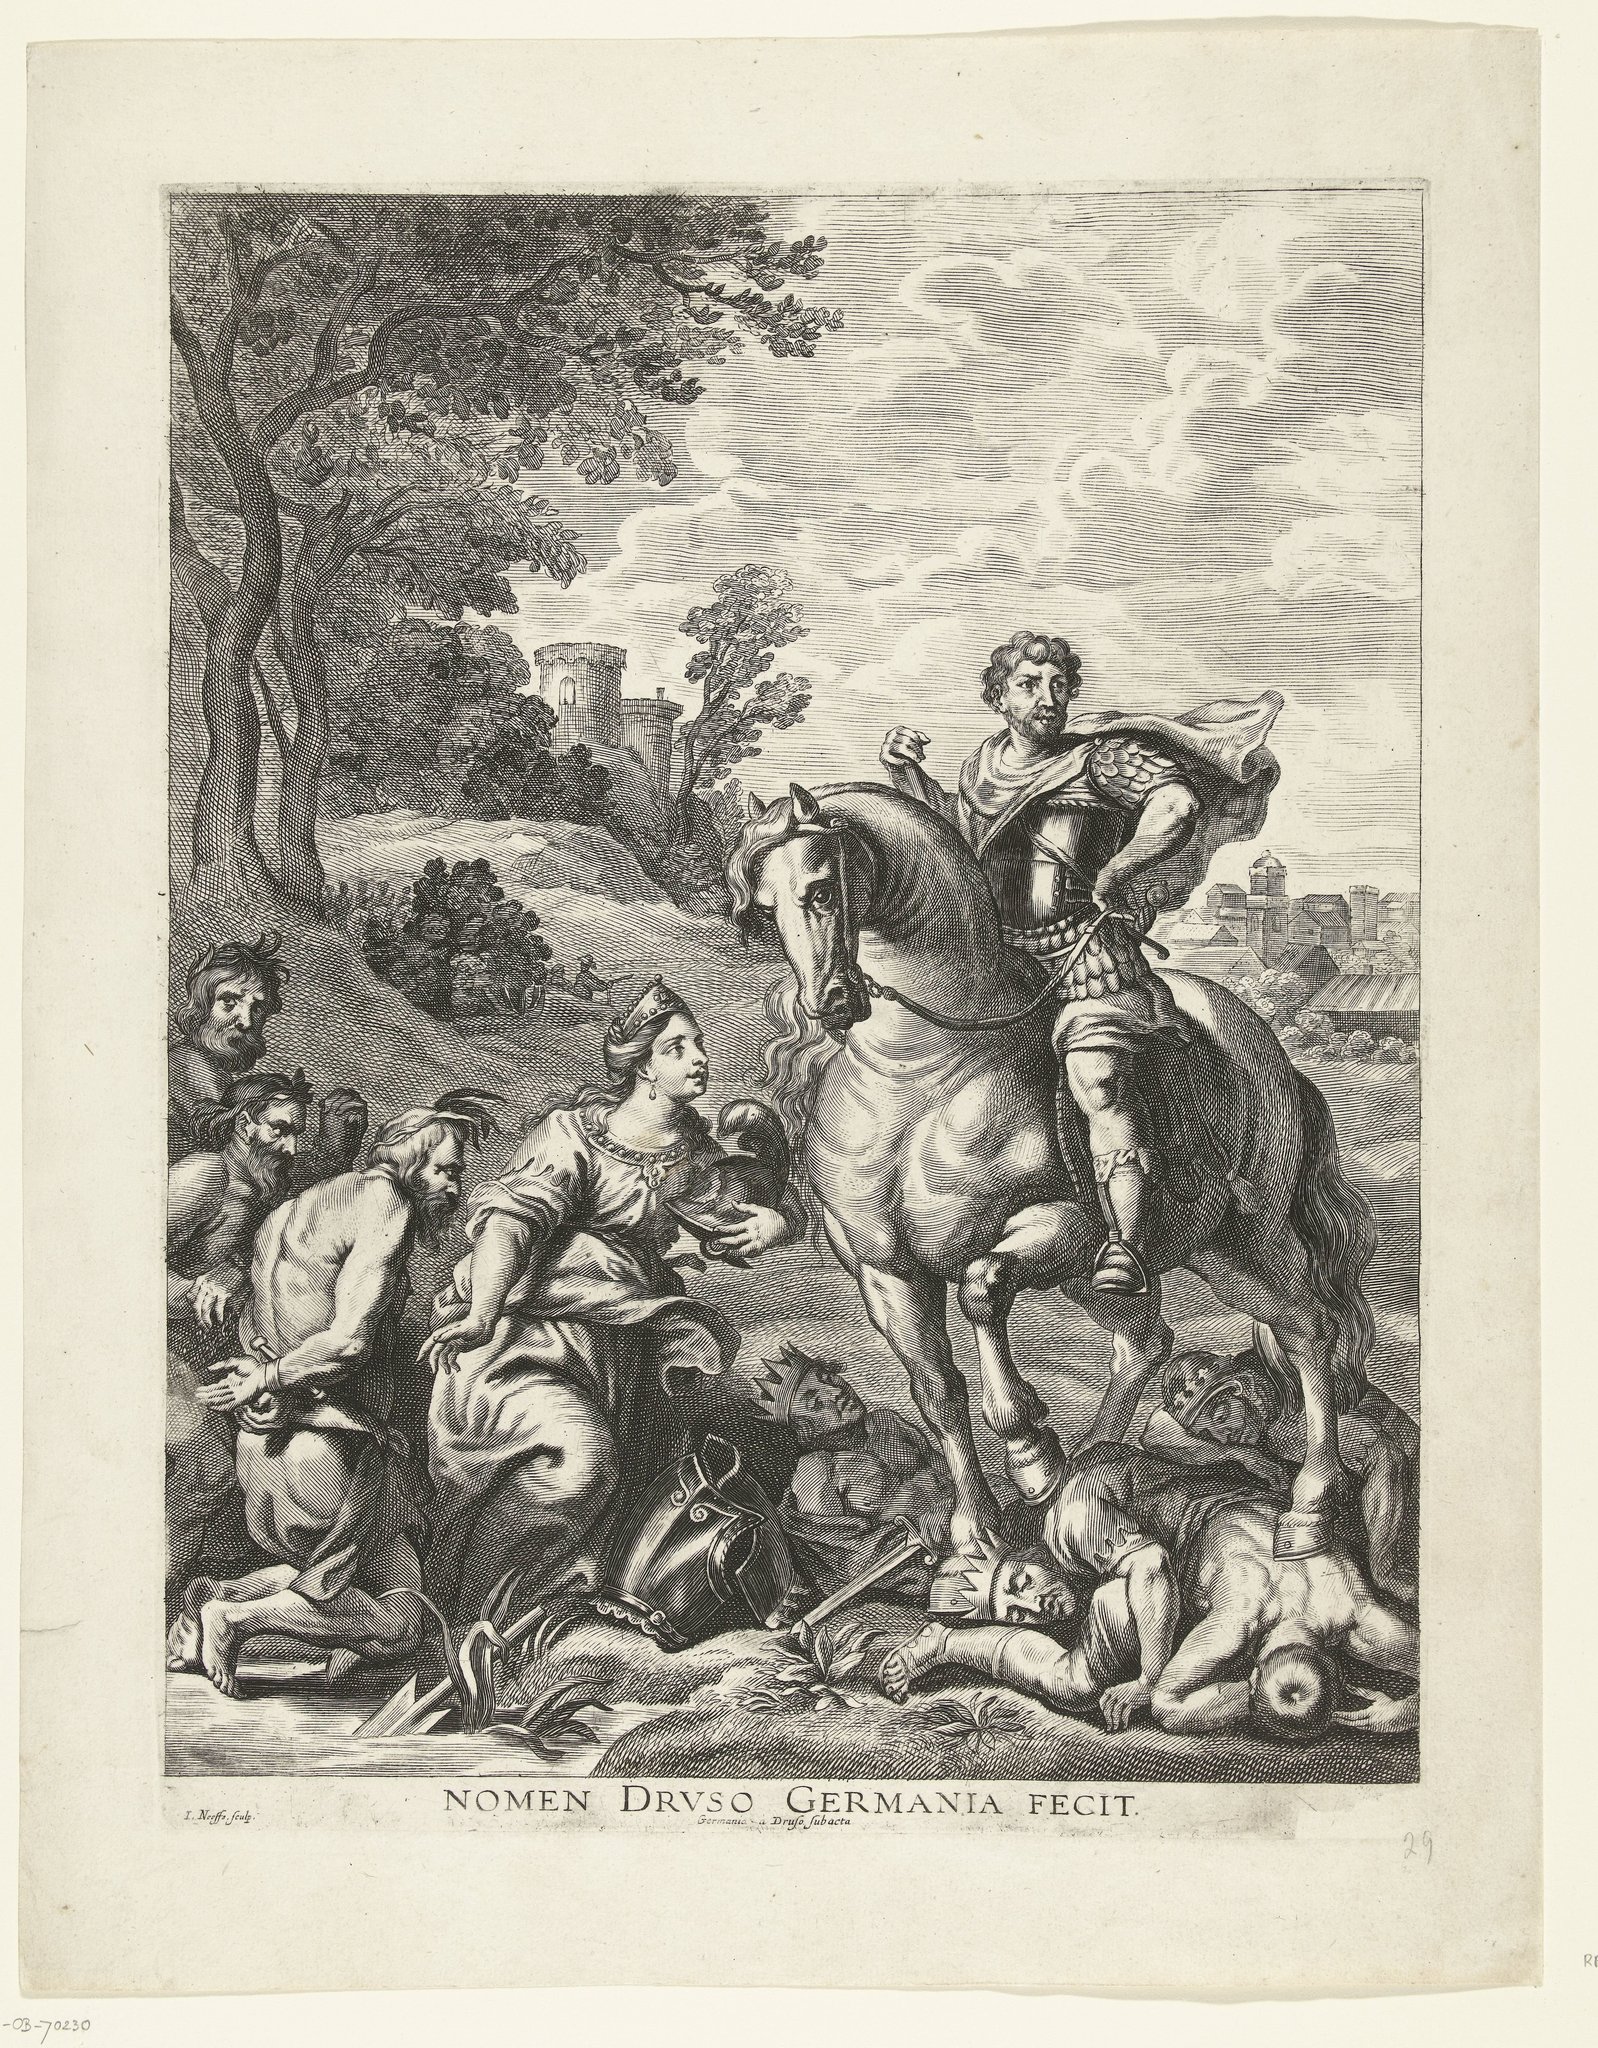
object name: print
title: II. Tabula. Germania à Druso subacta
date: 1635-1636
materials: paper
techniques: engraving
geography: southern netherlands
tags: brussels, landvoogd der zuidelijke nederlanden ferdinand van oostenrijk, conqueror (on horseback) tramples conquered, triumphal arch, ghent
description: Drusus onderwerpt Germania. De Romeinse veldheer Drusus te paard bij de overwonnen Germaanse volkeren. Hiermee verdient hij het recht om de naam Germanicu te dragen. Voorstelling op de achterzijde van de triomfpoort Arcus Caroli op de Vrijdagmarkt. Blad nr. 29 in een geheel van 42 platen die de uitgave van de beschrijving van de intocht van de Kardinaal Infant Ferdinand van Oostenrijk te Gent op 28 januari 1635 als de nieuwe landvoogd voor de Spaanse Nederlanden illustreren.